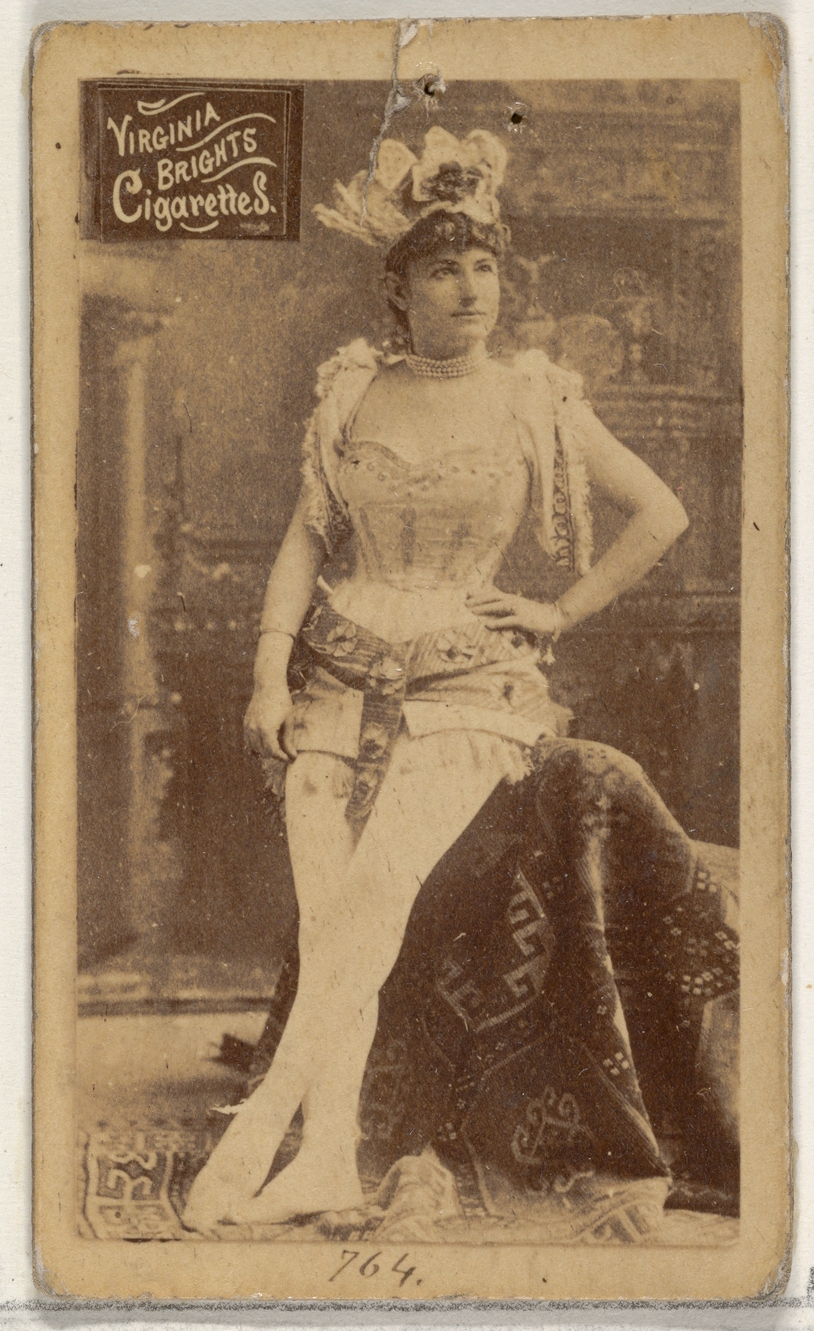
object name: photograph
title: Card 764, from the Actors and Actresses series (N45, Type 2) for Virginia Brights Cigarettes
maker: allen & ginter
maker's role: publisher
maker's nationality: american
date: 1888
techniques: albumen silver print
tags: portraits,women,actresses